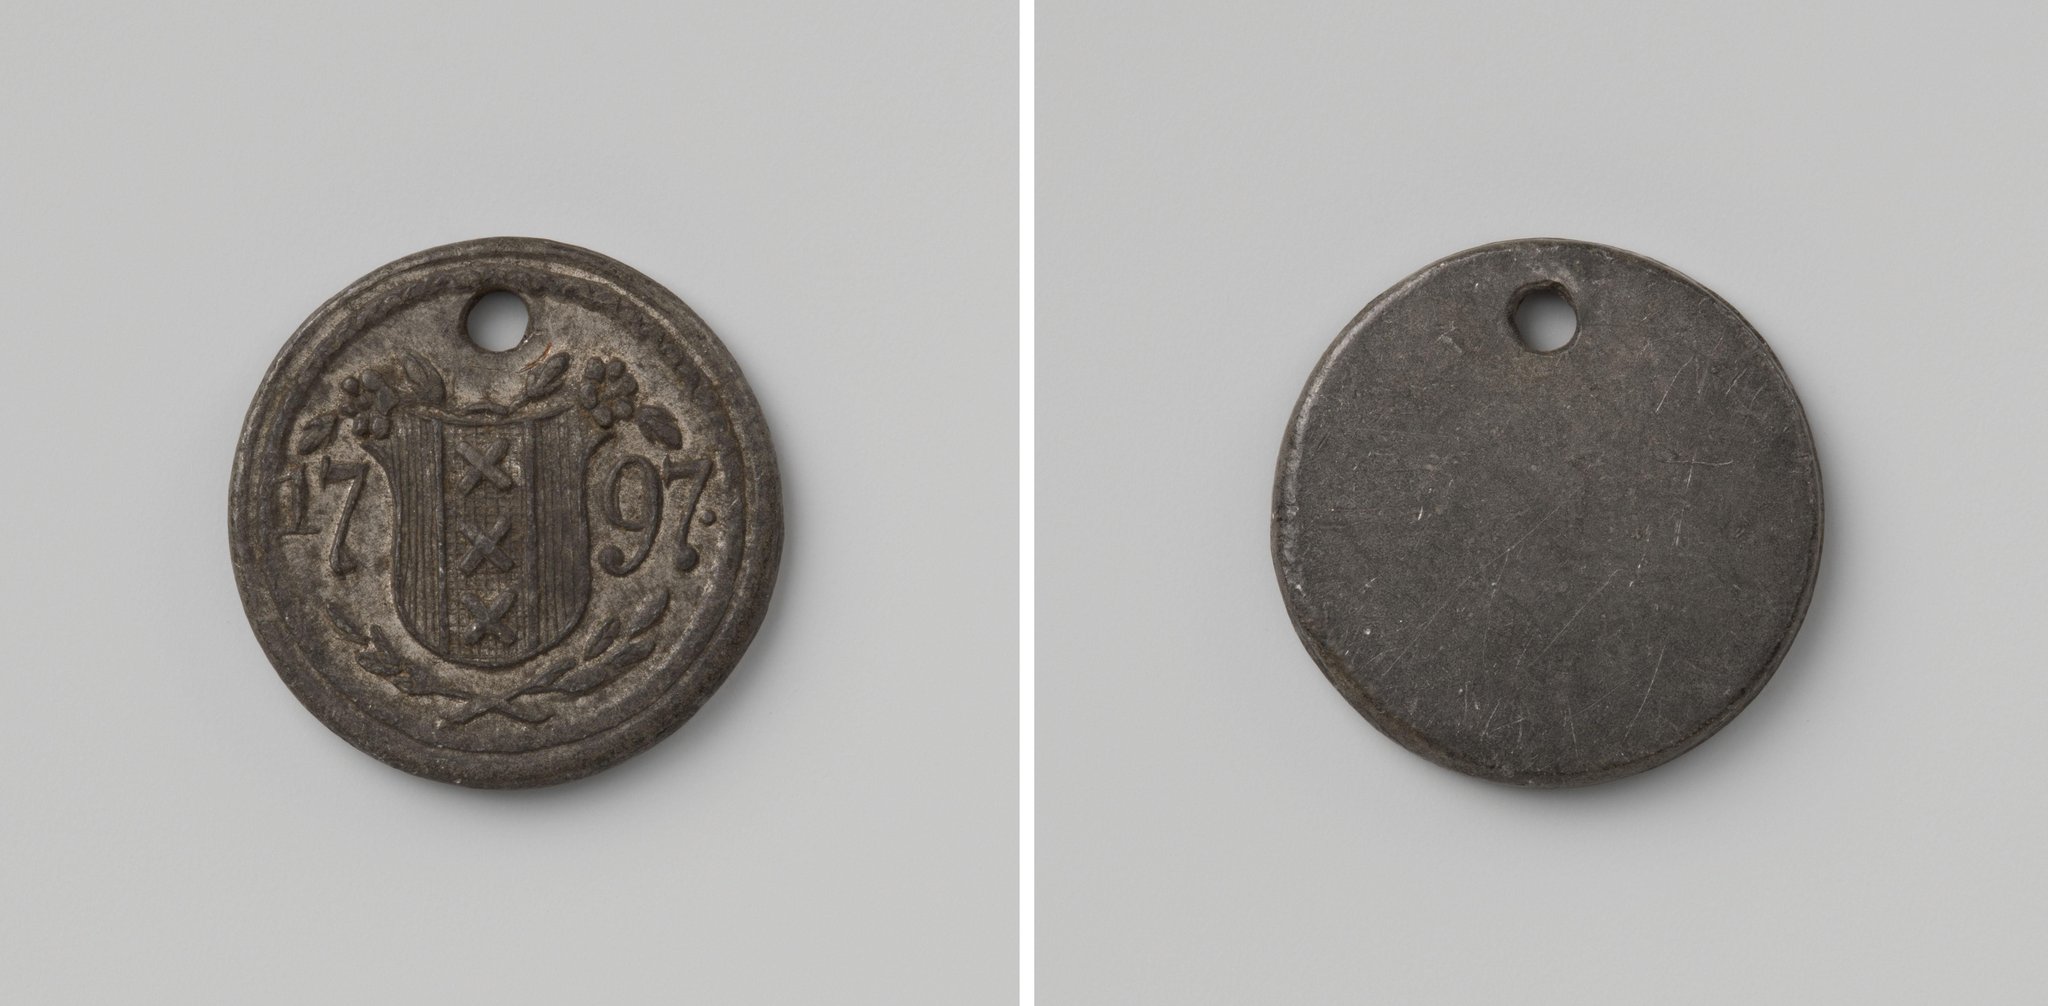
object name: hondenbelastingloodje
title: Aalmoezeniersweeshuis te Amsterdam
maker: Anonymous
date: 1797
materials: tin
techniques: striking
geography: amsterdam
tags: amsterdam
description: eenzijdig loodje met gat erin. Voorzijde: wapenschild op twee gekruiste bladertakken tussen jaartal. Keerzijde: blanco